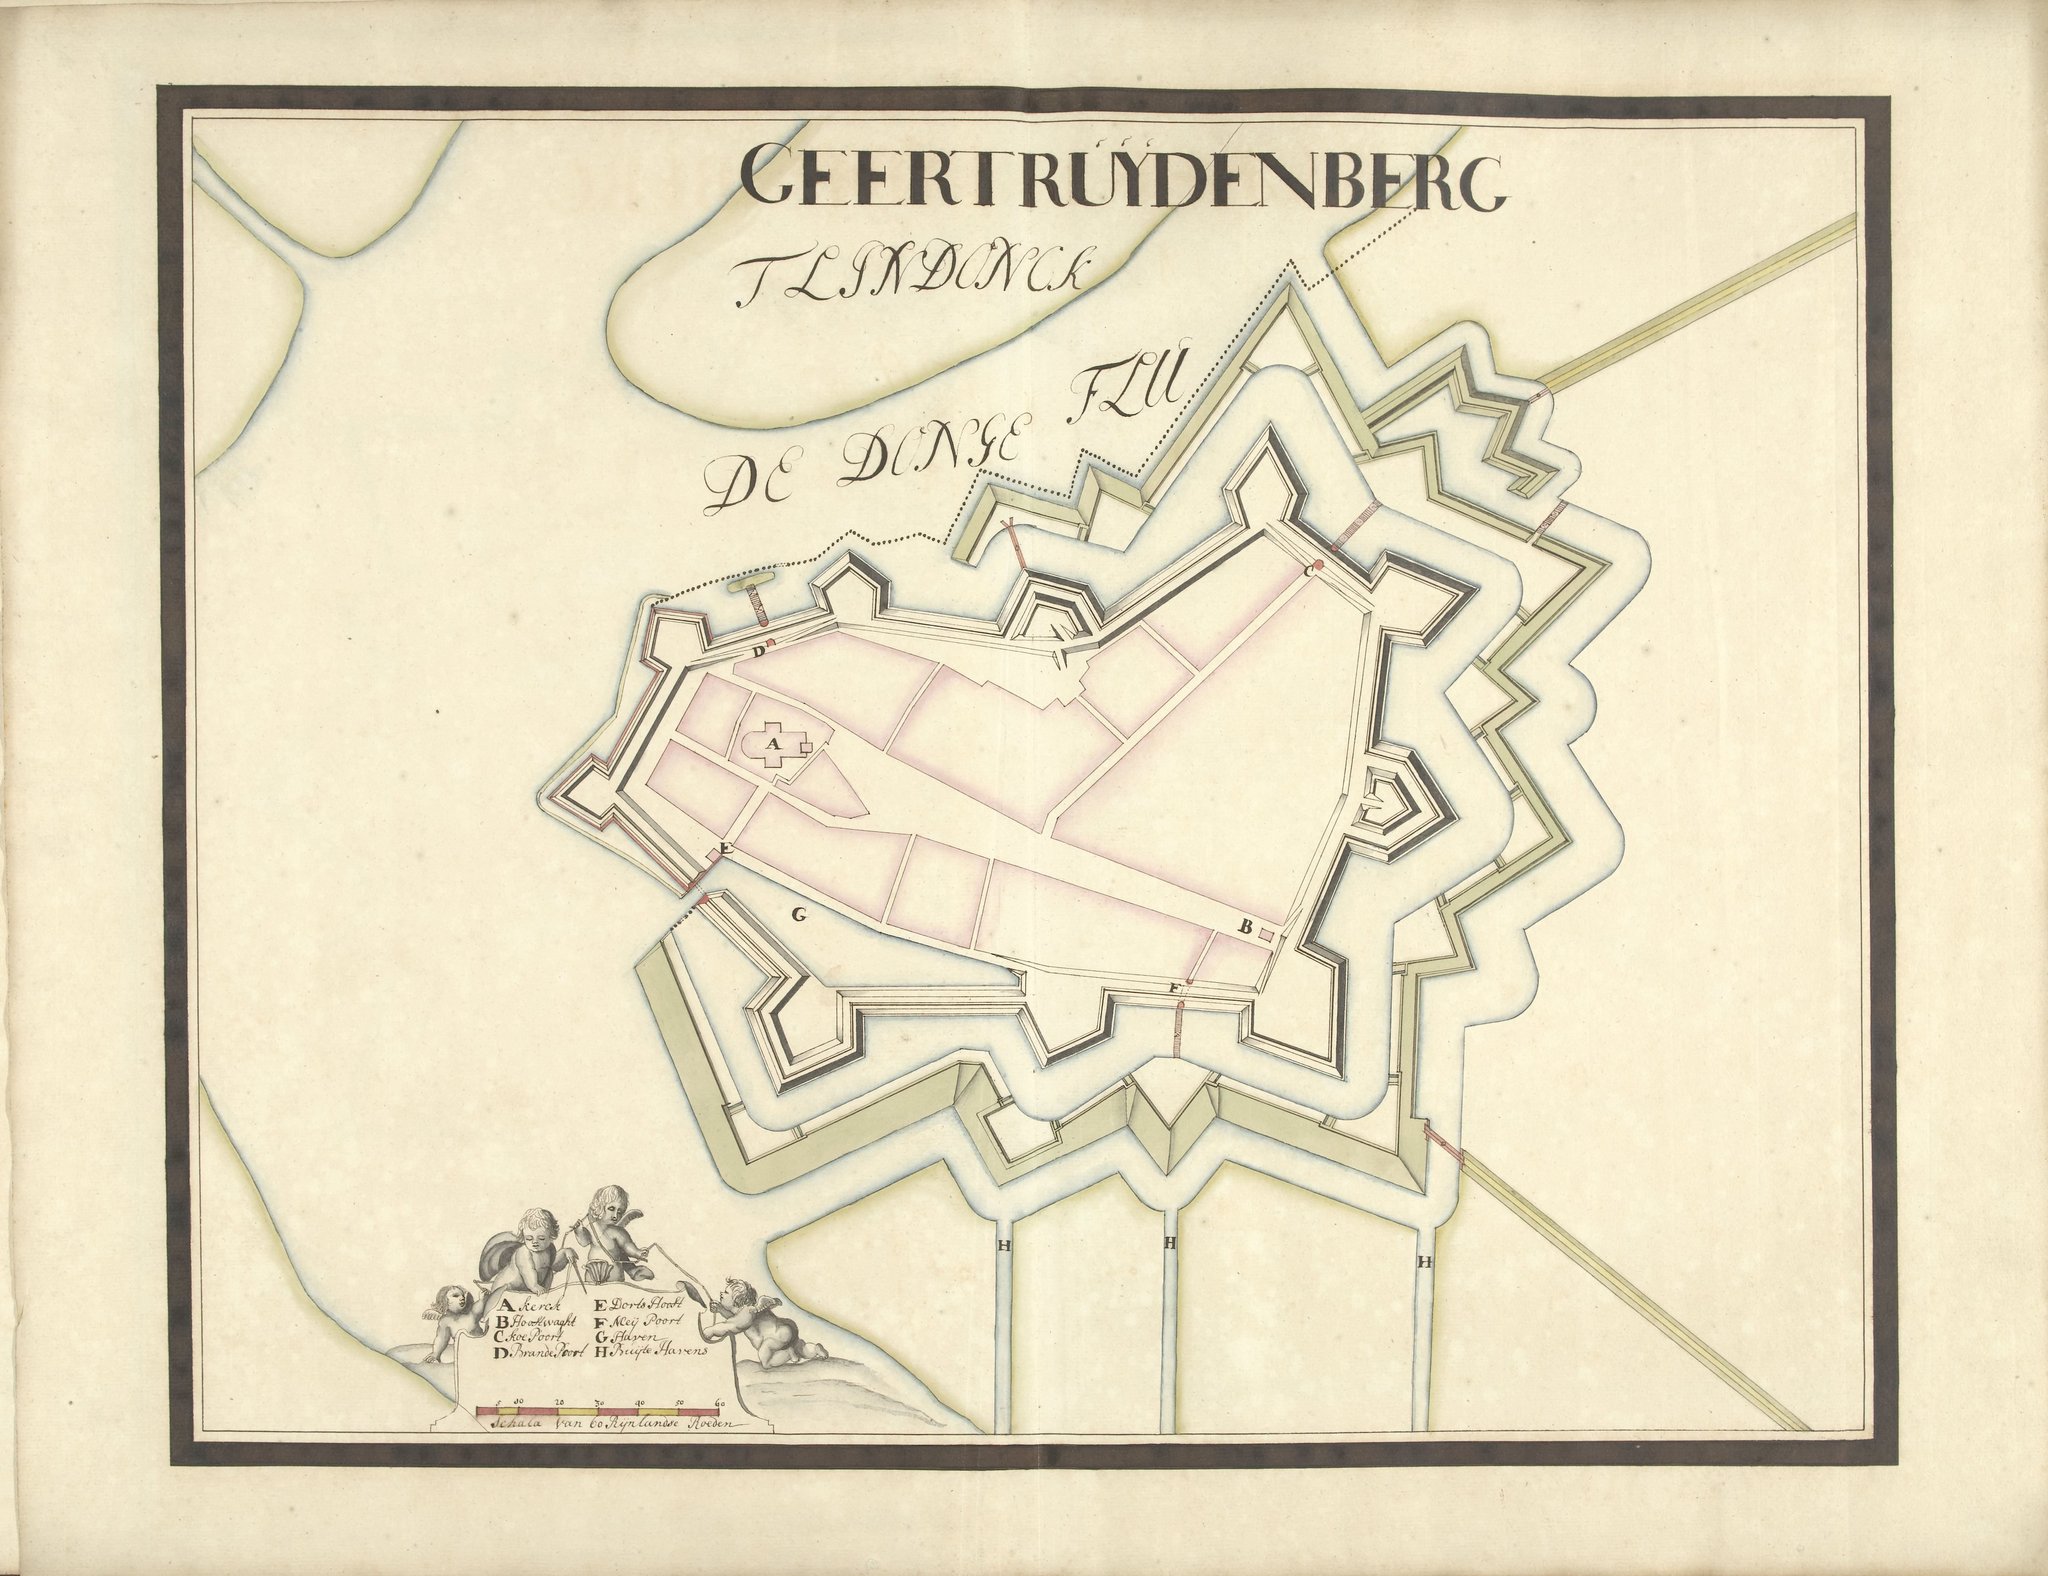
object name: drawing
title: Geertruydenberg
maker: samuel du ry de champdoré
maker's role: draughtsman, engineer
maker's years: 1651-1729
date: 1701-1715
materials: paper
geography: netherlands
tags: fortress, maps of cities, geertruidenberg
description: Plattegrond van de versterkingen om de stad Geertruidenberg, ca. 1701-1715. Linksonder een cartouche met de legenda A-H in het Nederlands, met vier putti met passers en meetlint. Onderdeel van een verzameling getekende plannen van versterkte plaatsen in Nederland en omringende landen ten tijde van de Spaanse Successieoorlog (deel A).